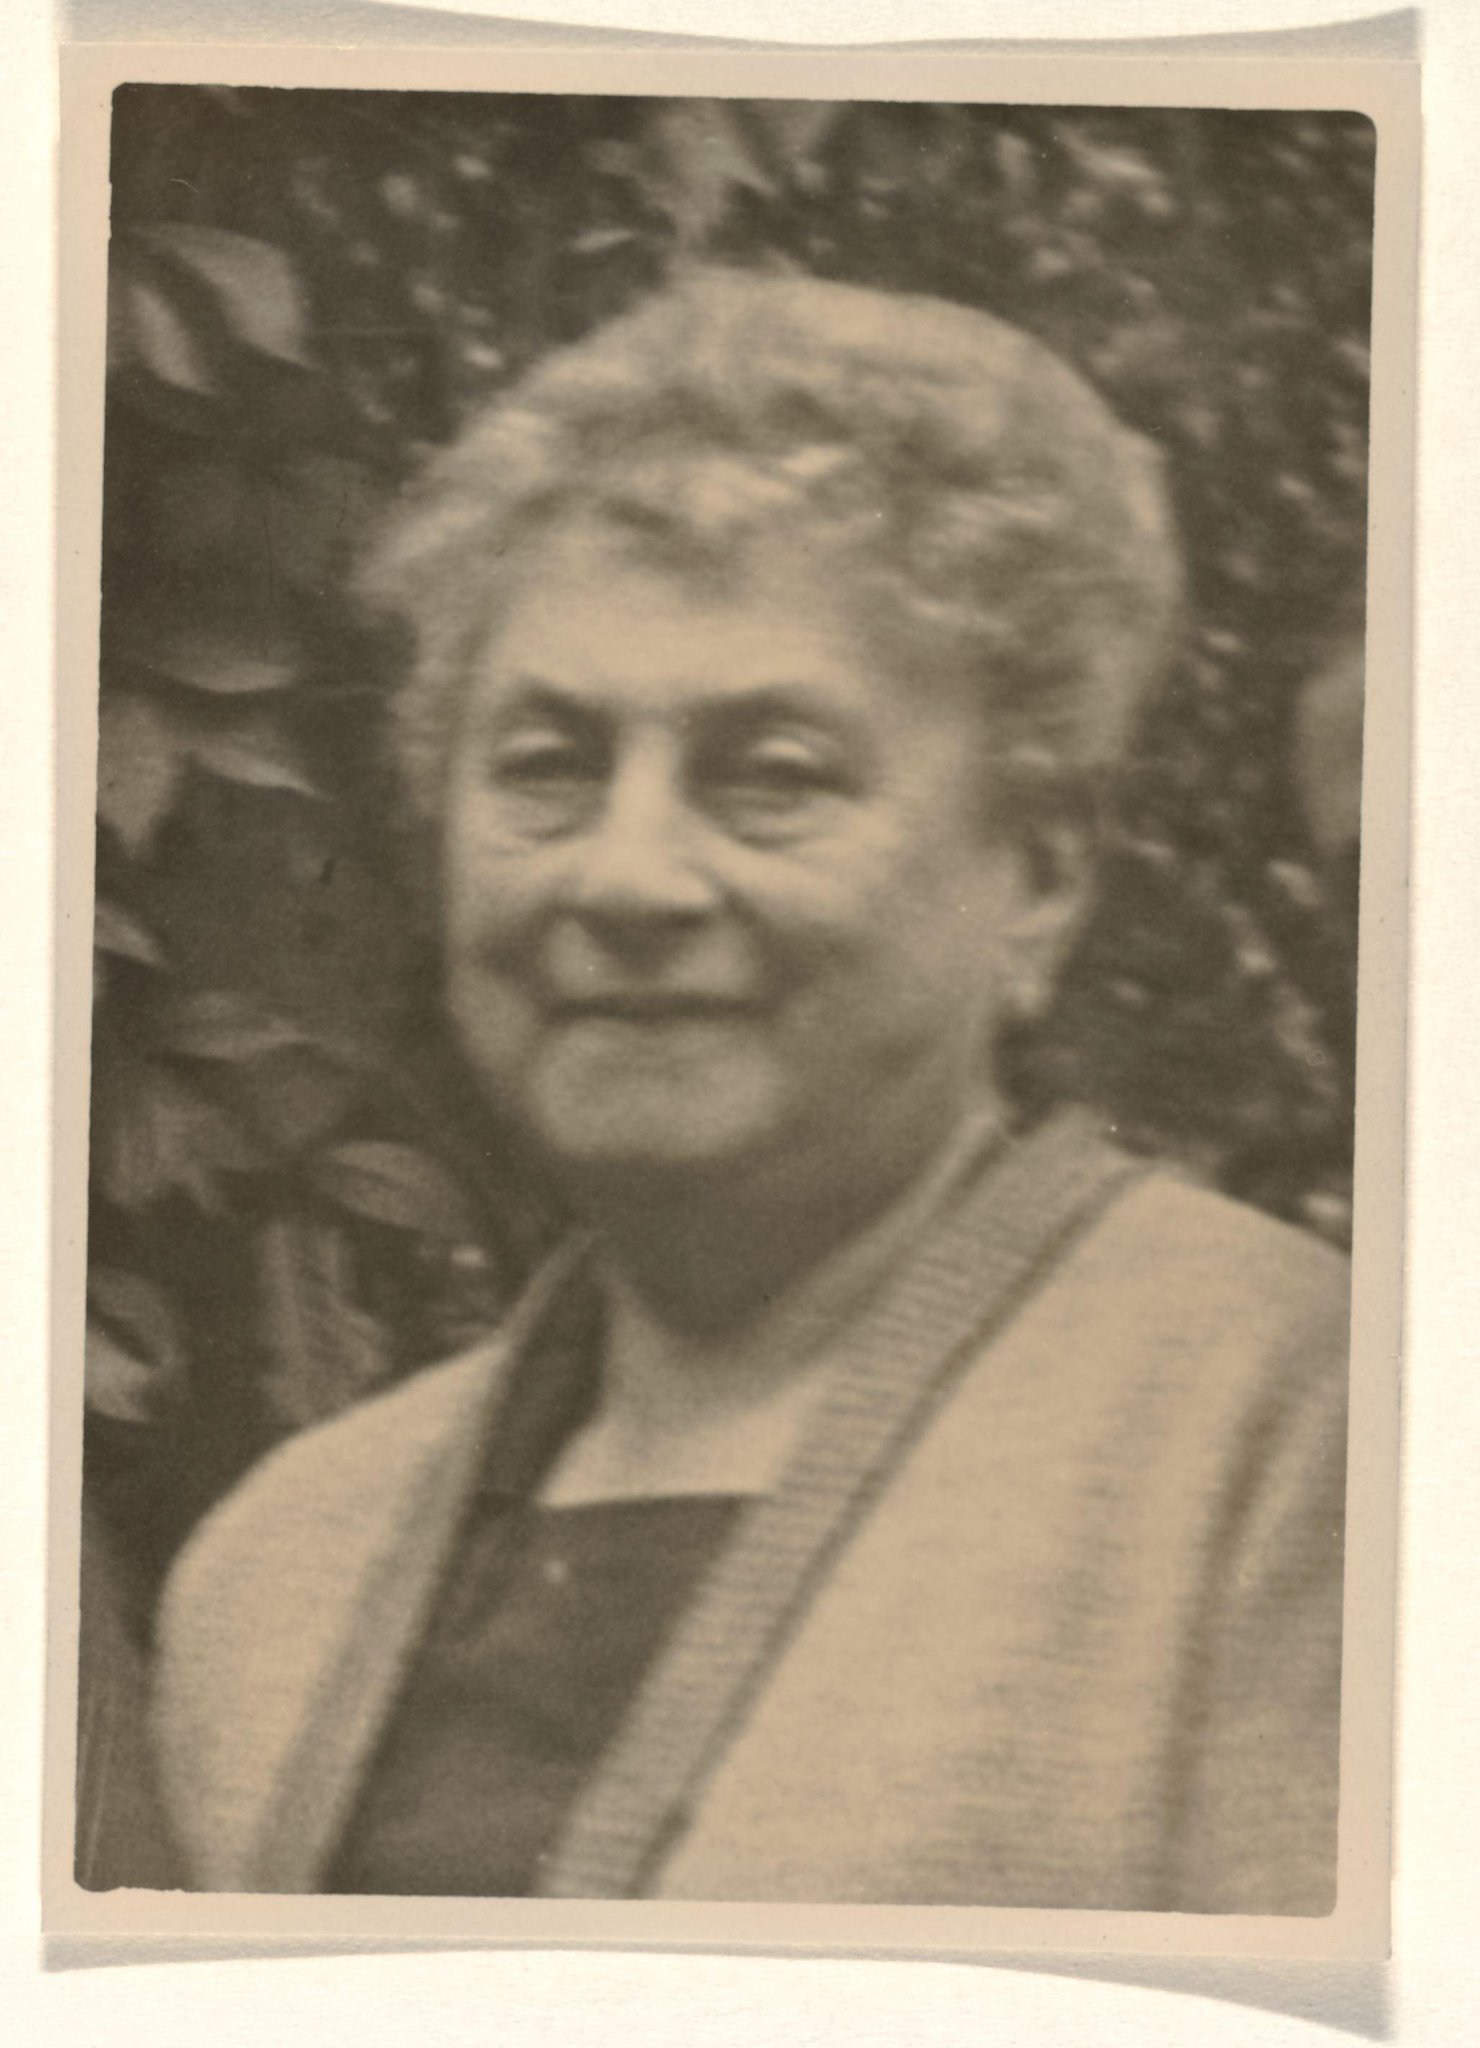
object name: photograph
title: Portret van Josefone Moos-Levi, gekleed in een kleed met verticale band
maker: Anonymous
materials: photographic support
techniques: gelatin silver print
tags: josefine moos-levi